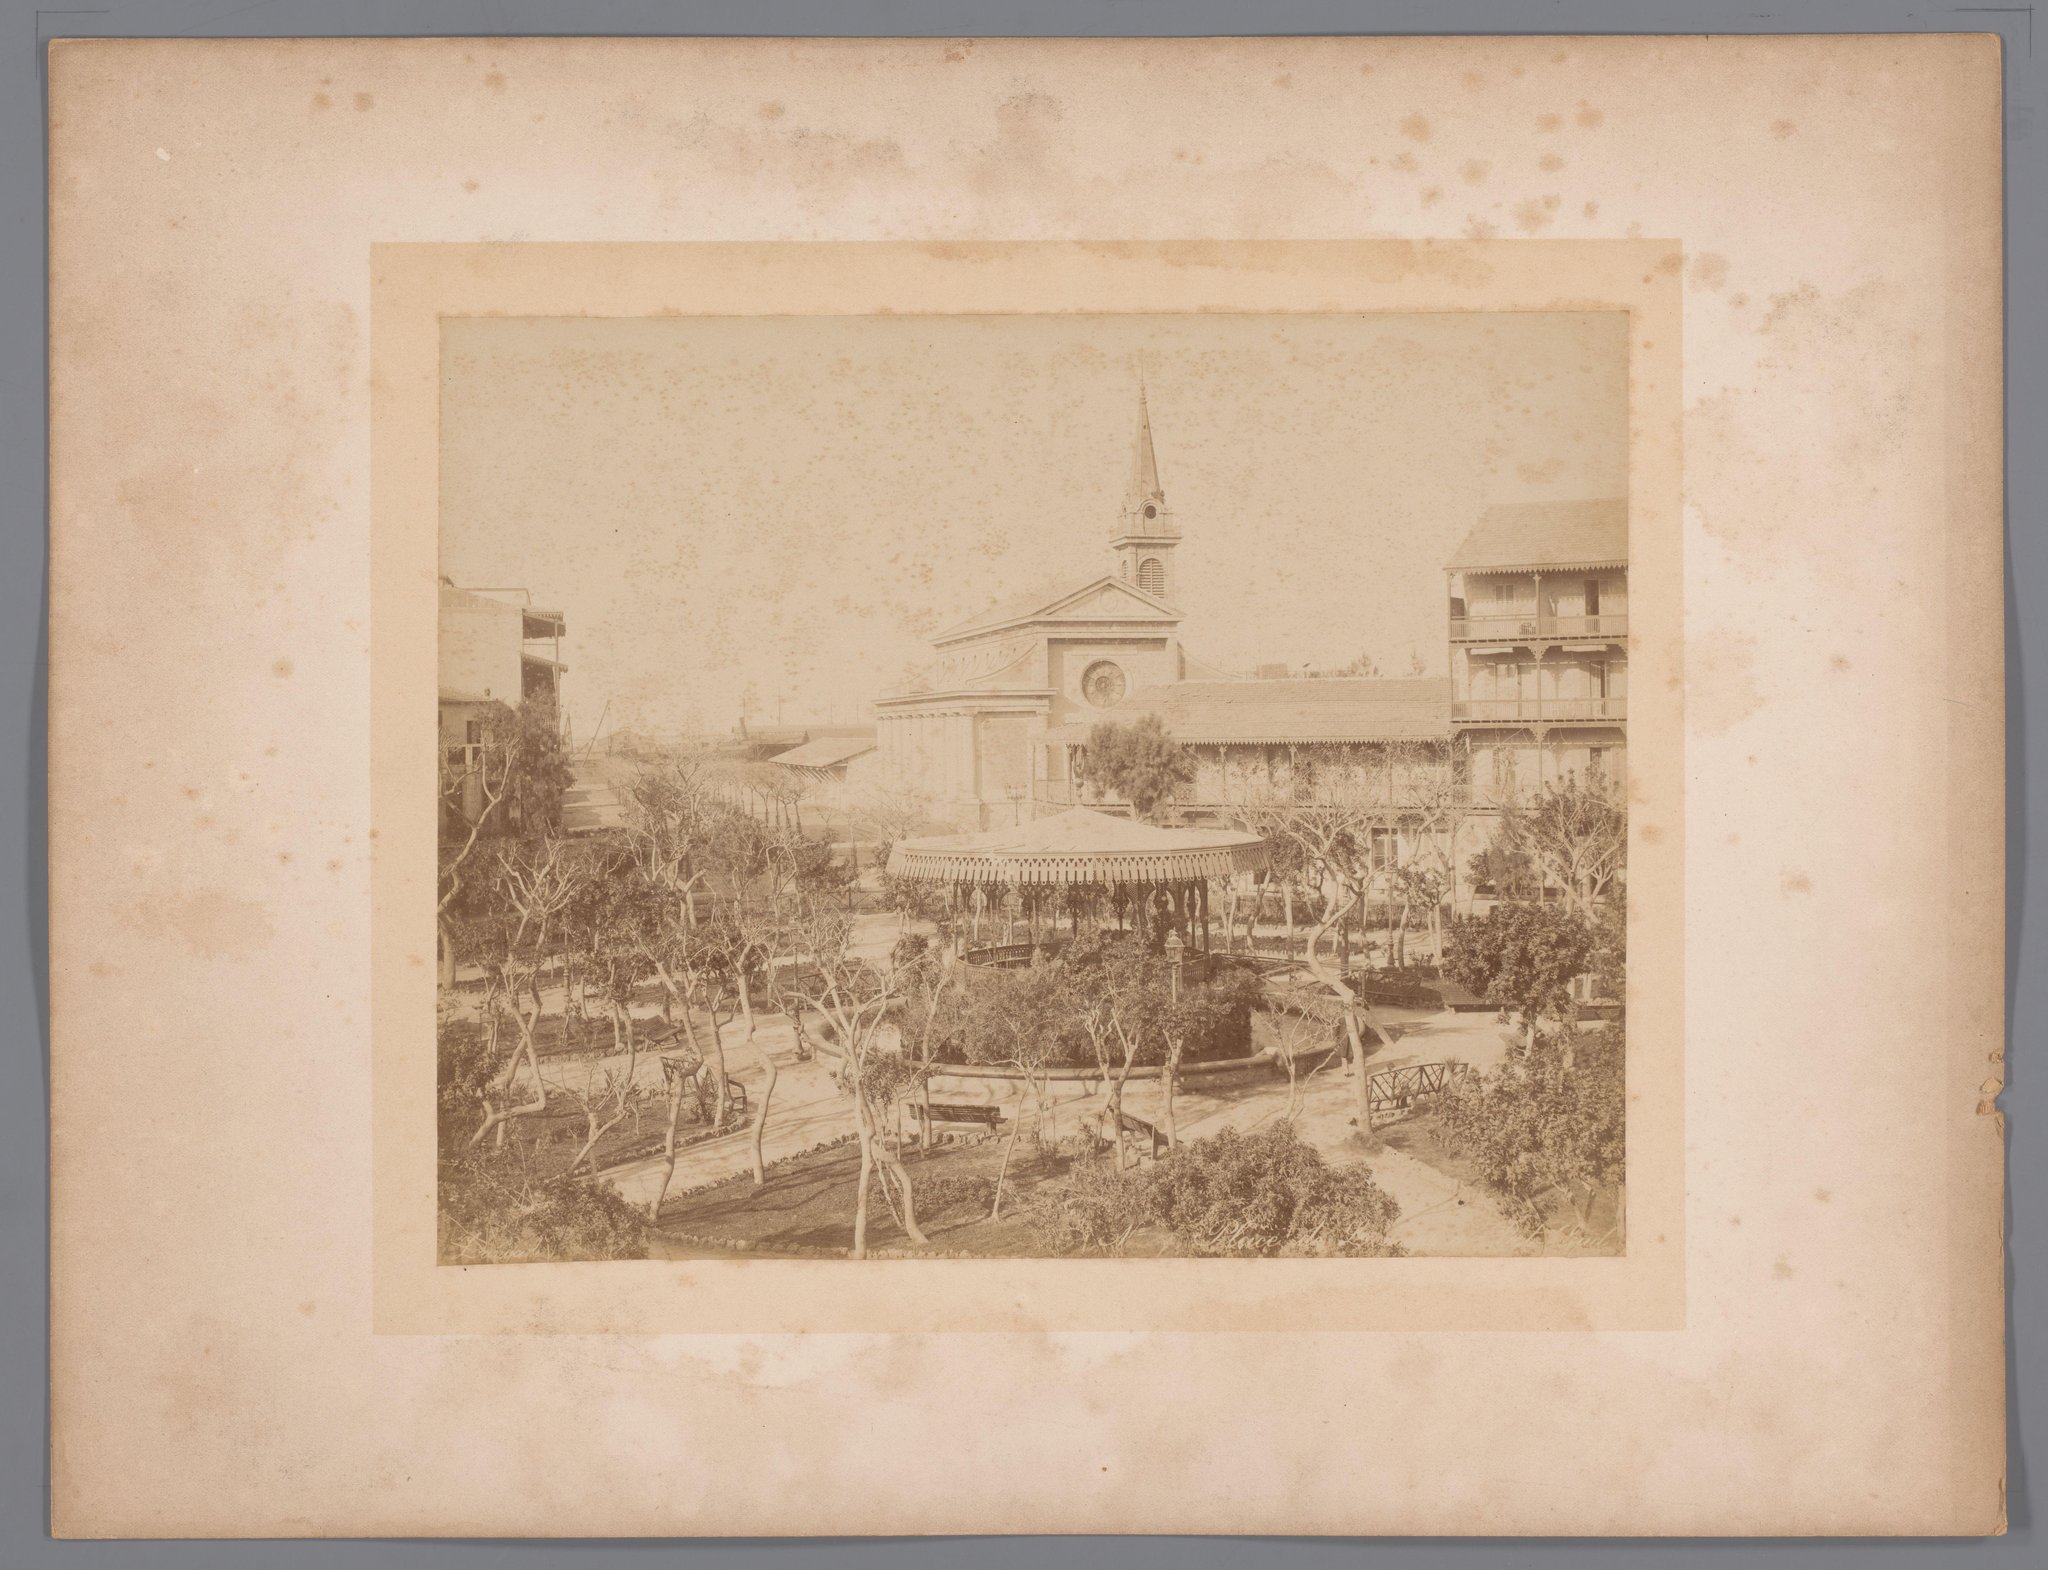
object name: photograph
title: Place de Lesseps, Port Saïd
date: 1870-1910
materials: cardboard, paper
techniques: albumen print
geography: port said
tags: square, place, circus, etc., merry-go-round, roundabout; chair o'plane, church (exterior)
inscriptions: inscription: ‘Place de Lesseps Port Said/ foto Zangaki/ Port Said’